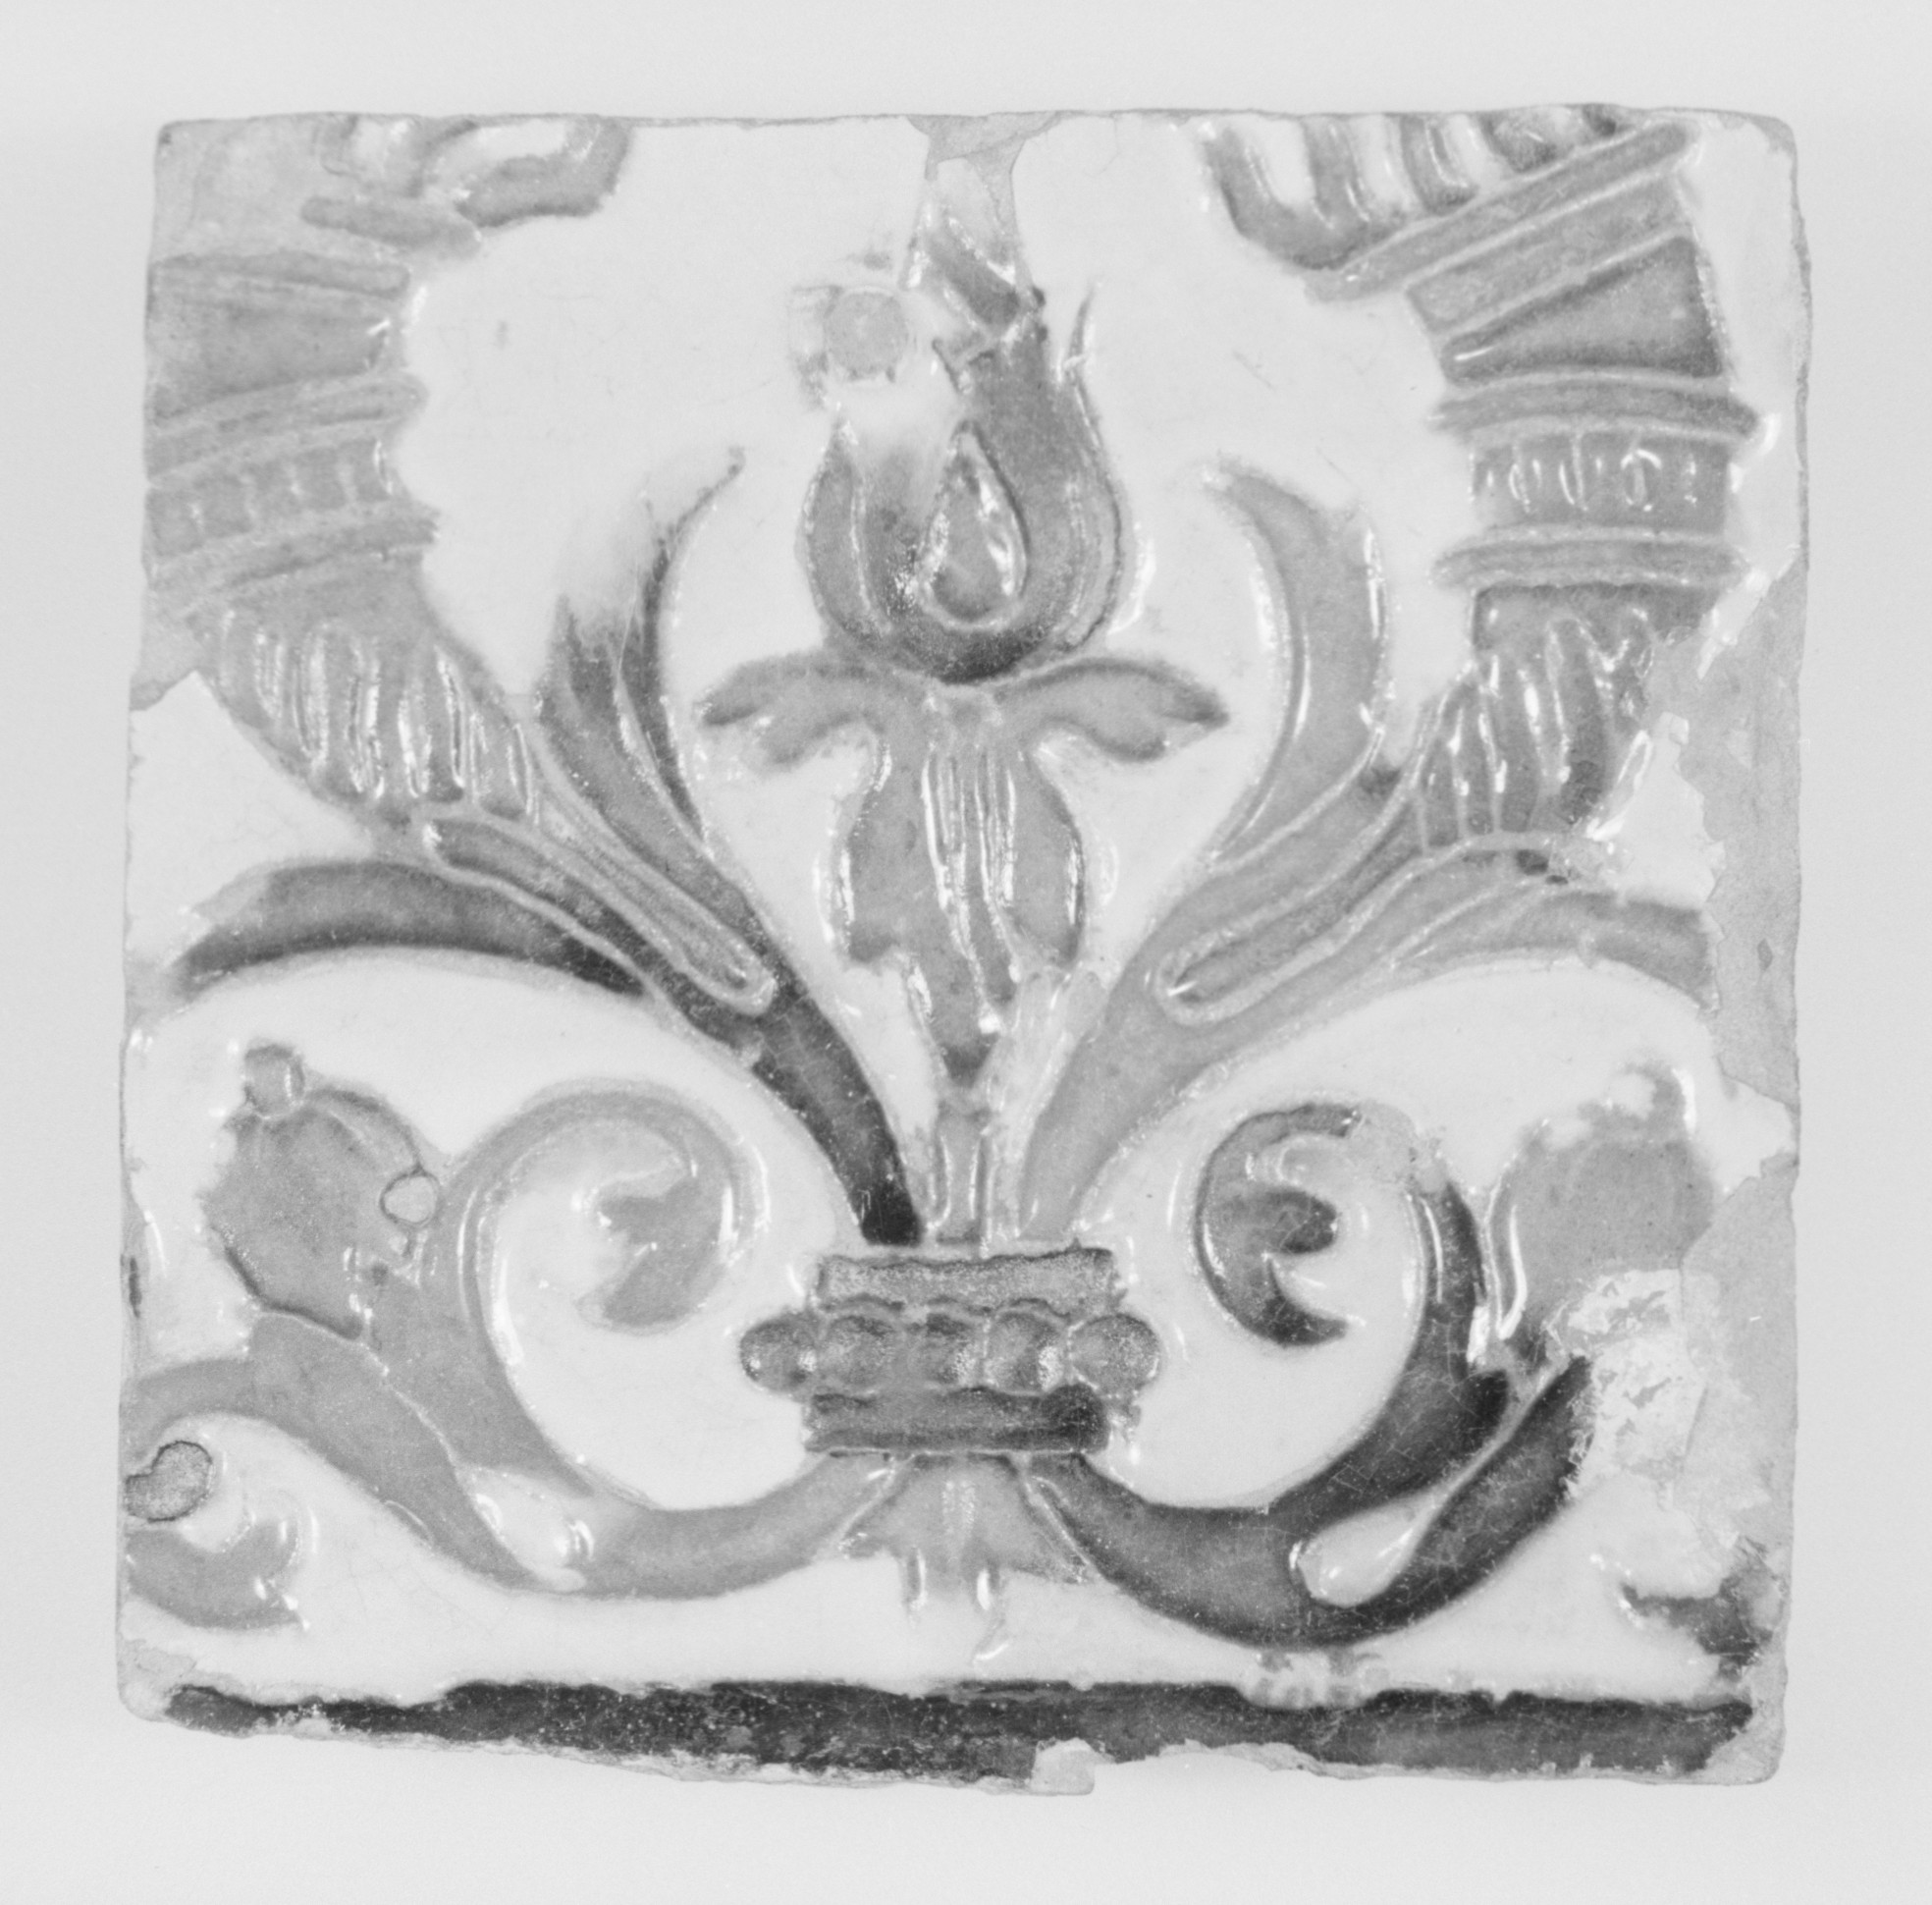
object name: wall tile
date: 1501-1600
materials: earthenware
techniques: glazing